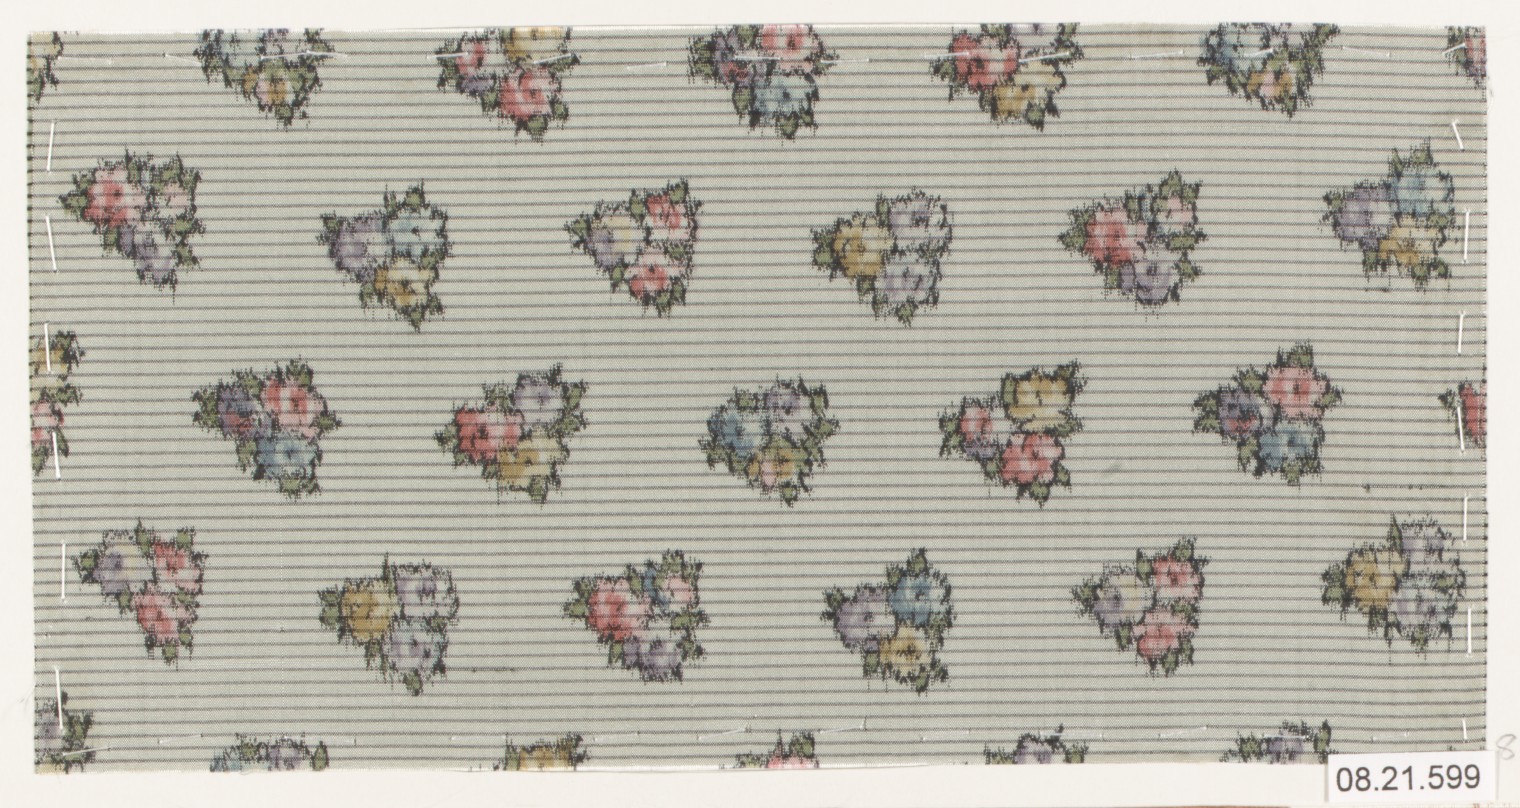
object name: textile sample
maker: Anonymous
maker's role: designer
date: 1900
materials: silk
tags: flowers